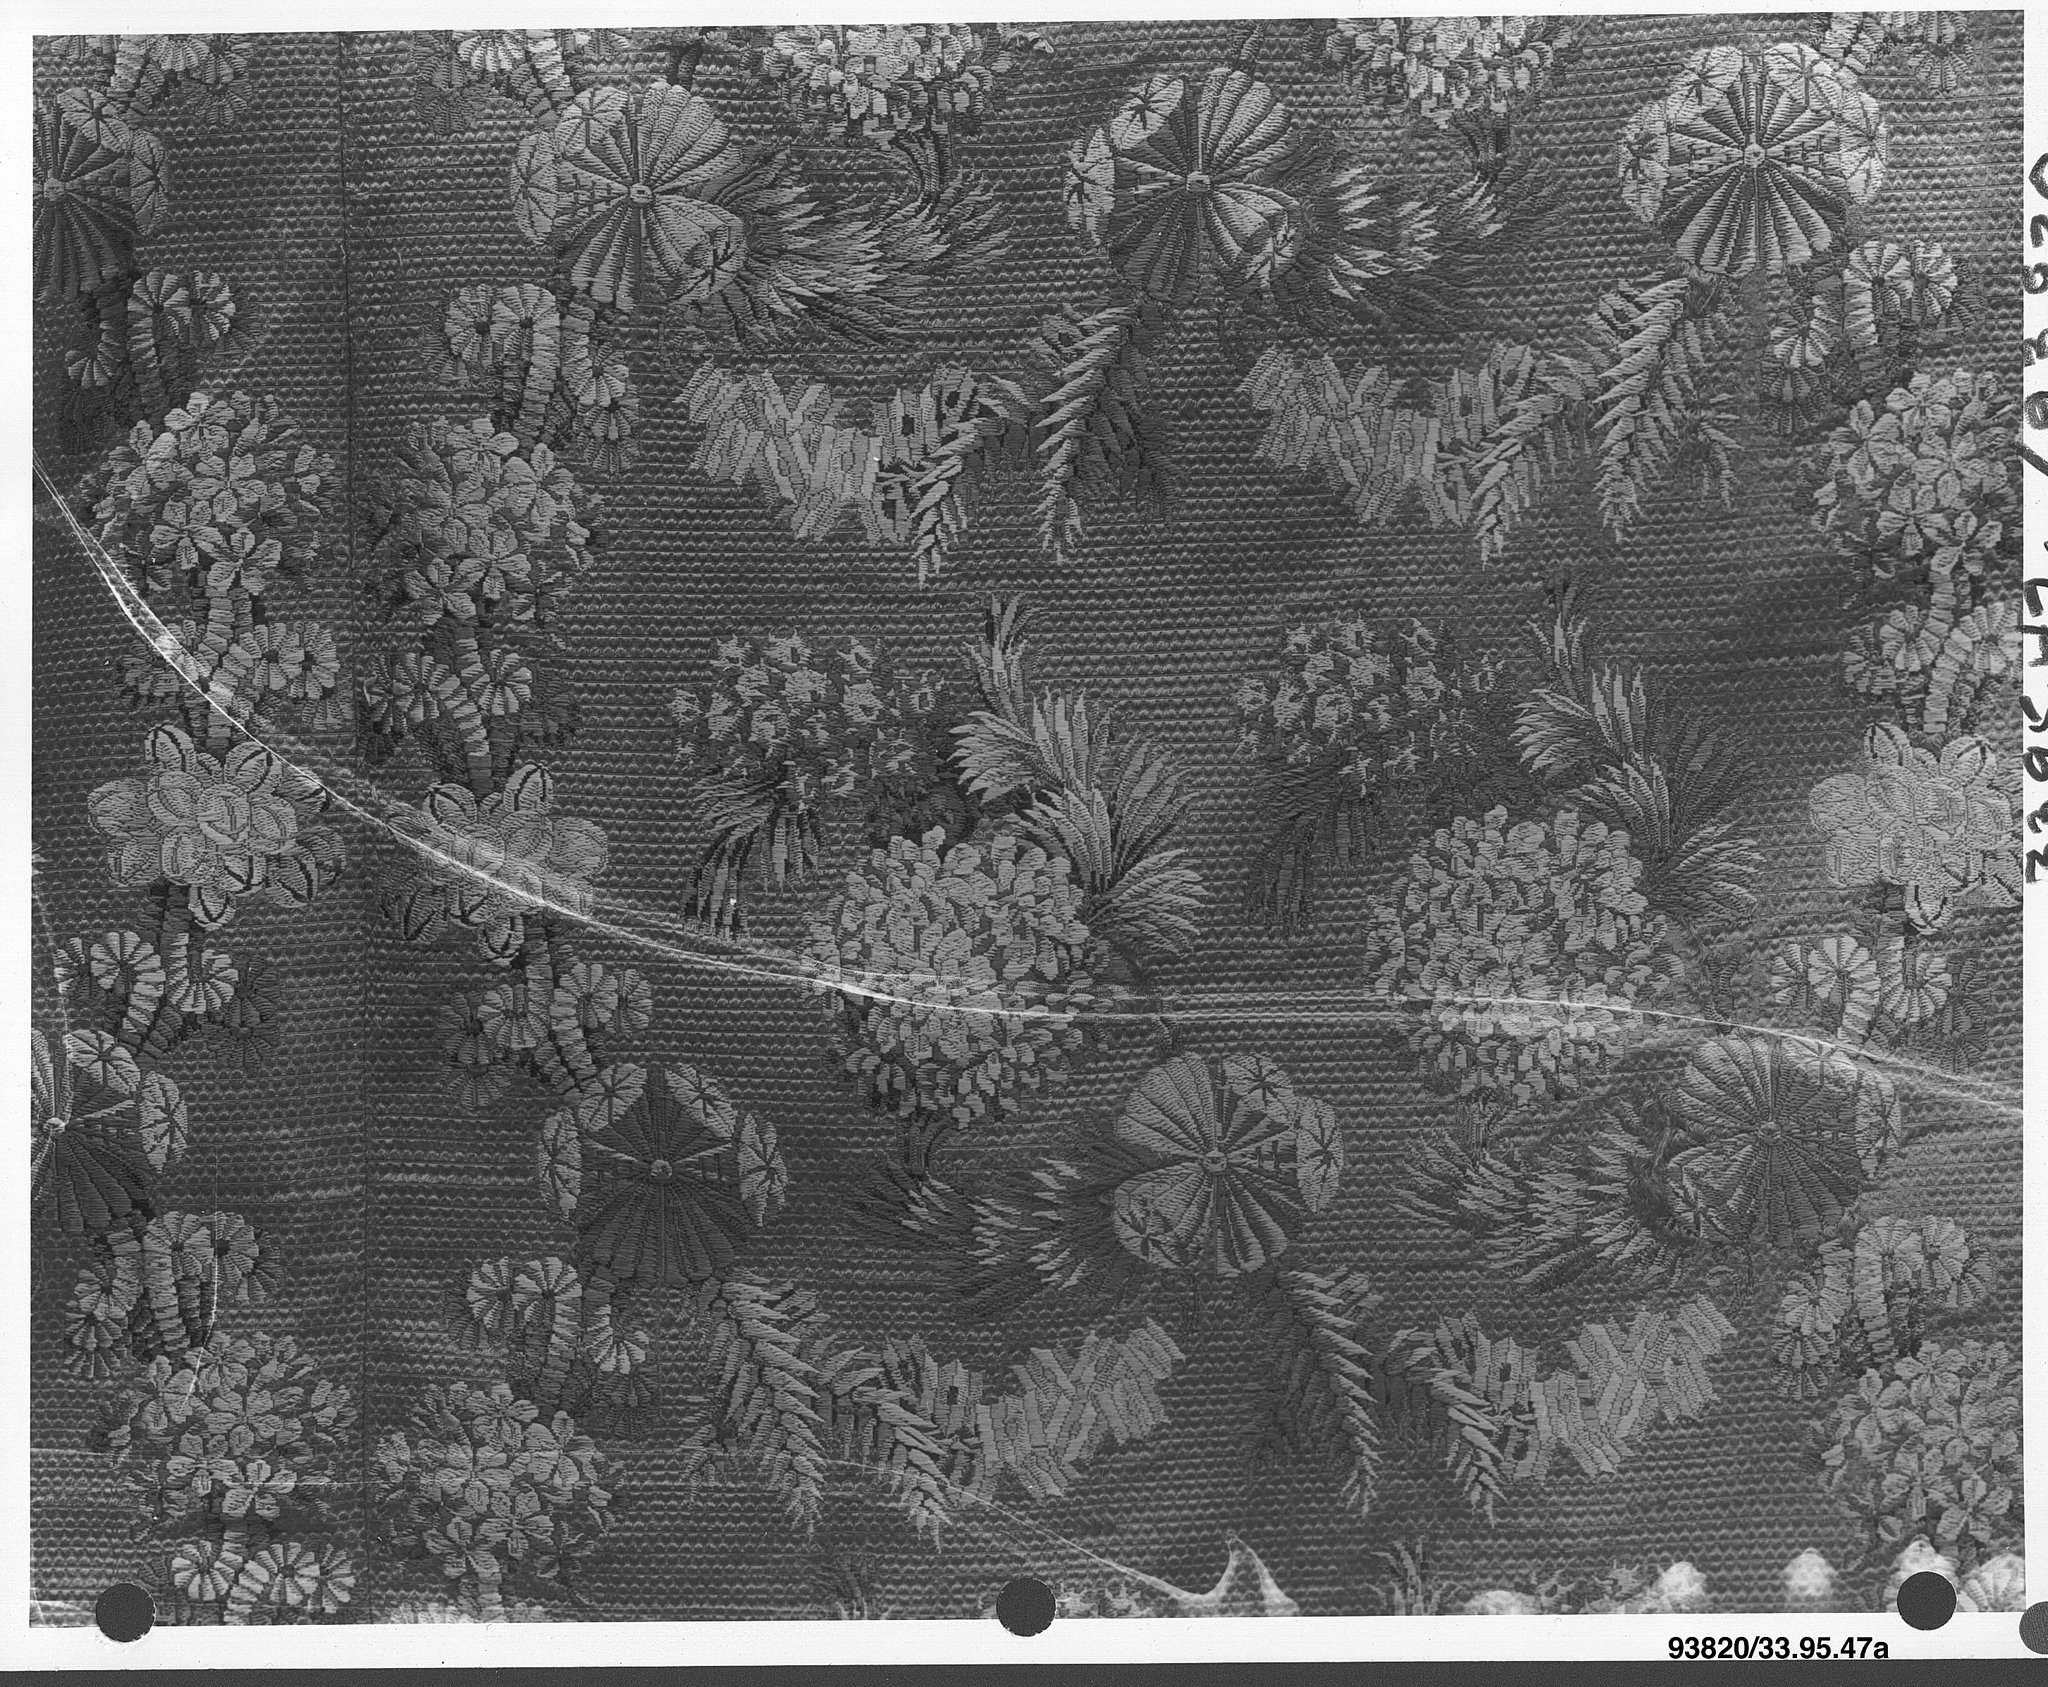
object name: piece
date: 1760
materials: silk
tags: flowers,leaves